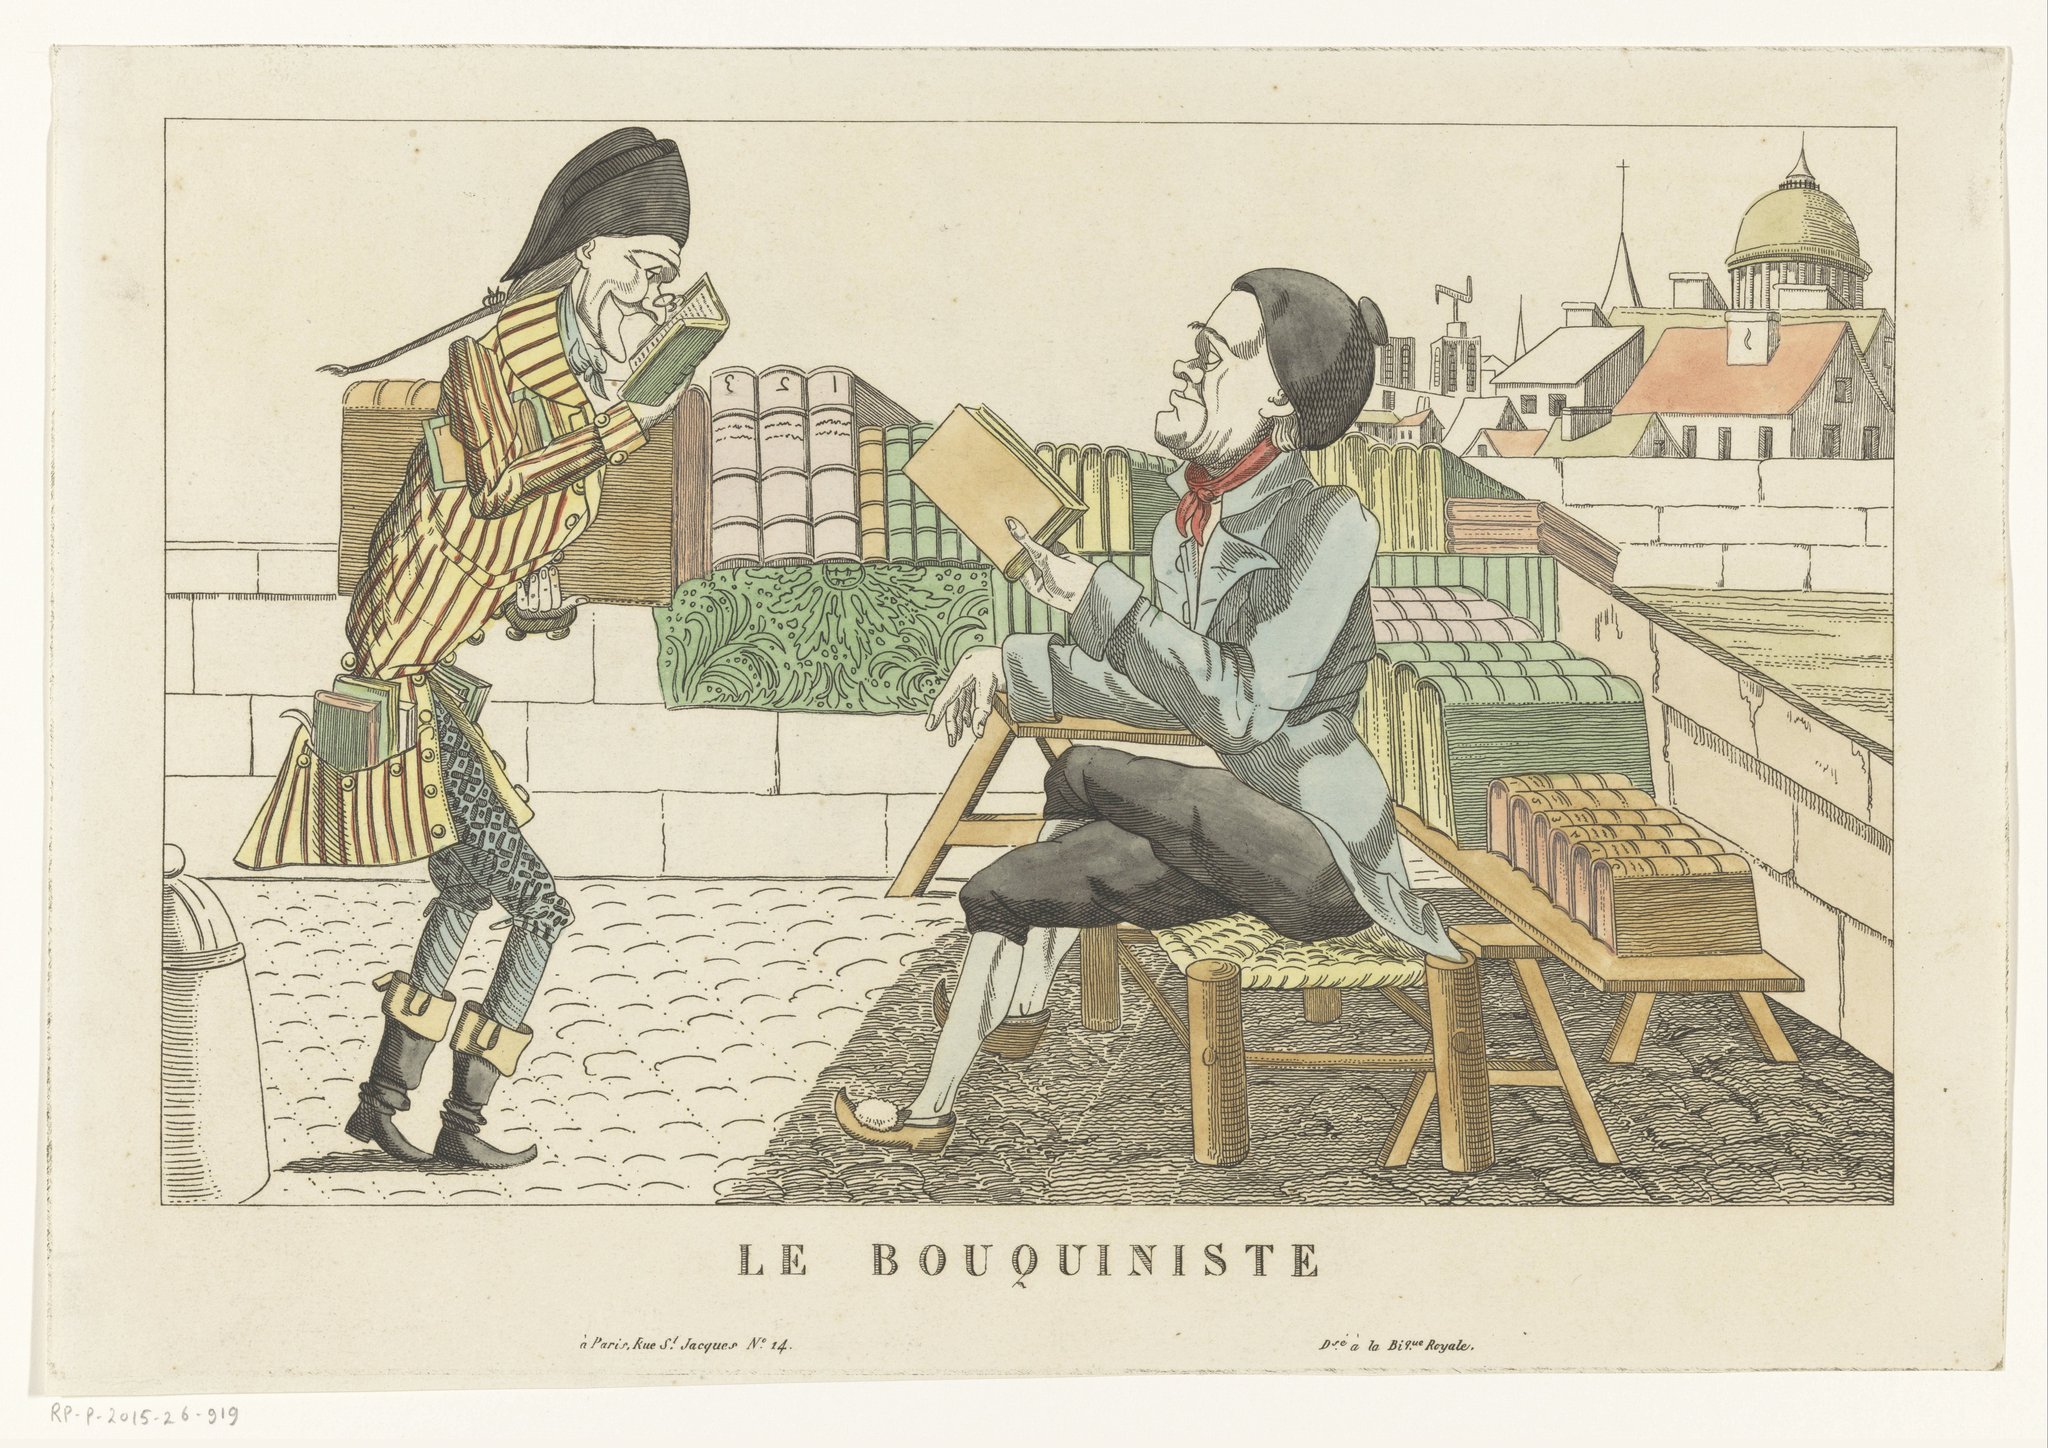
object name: print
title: Boekhandelaar en een klant op een kade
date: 1814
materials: paper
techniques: etching, hand coloring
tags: book-stall, kiosk, political caricatures and satires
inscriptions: collector's mark: Lugt 4779, collector's mark: Lugt 2228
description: Een boekhandelaar heeft zijn voorraad uitgestald op een kademuur, zelf zit hij op een krukje. Voor hem staat een klant met een boek in zijn hand, zijn jaszakken puilen uit van de boeken.